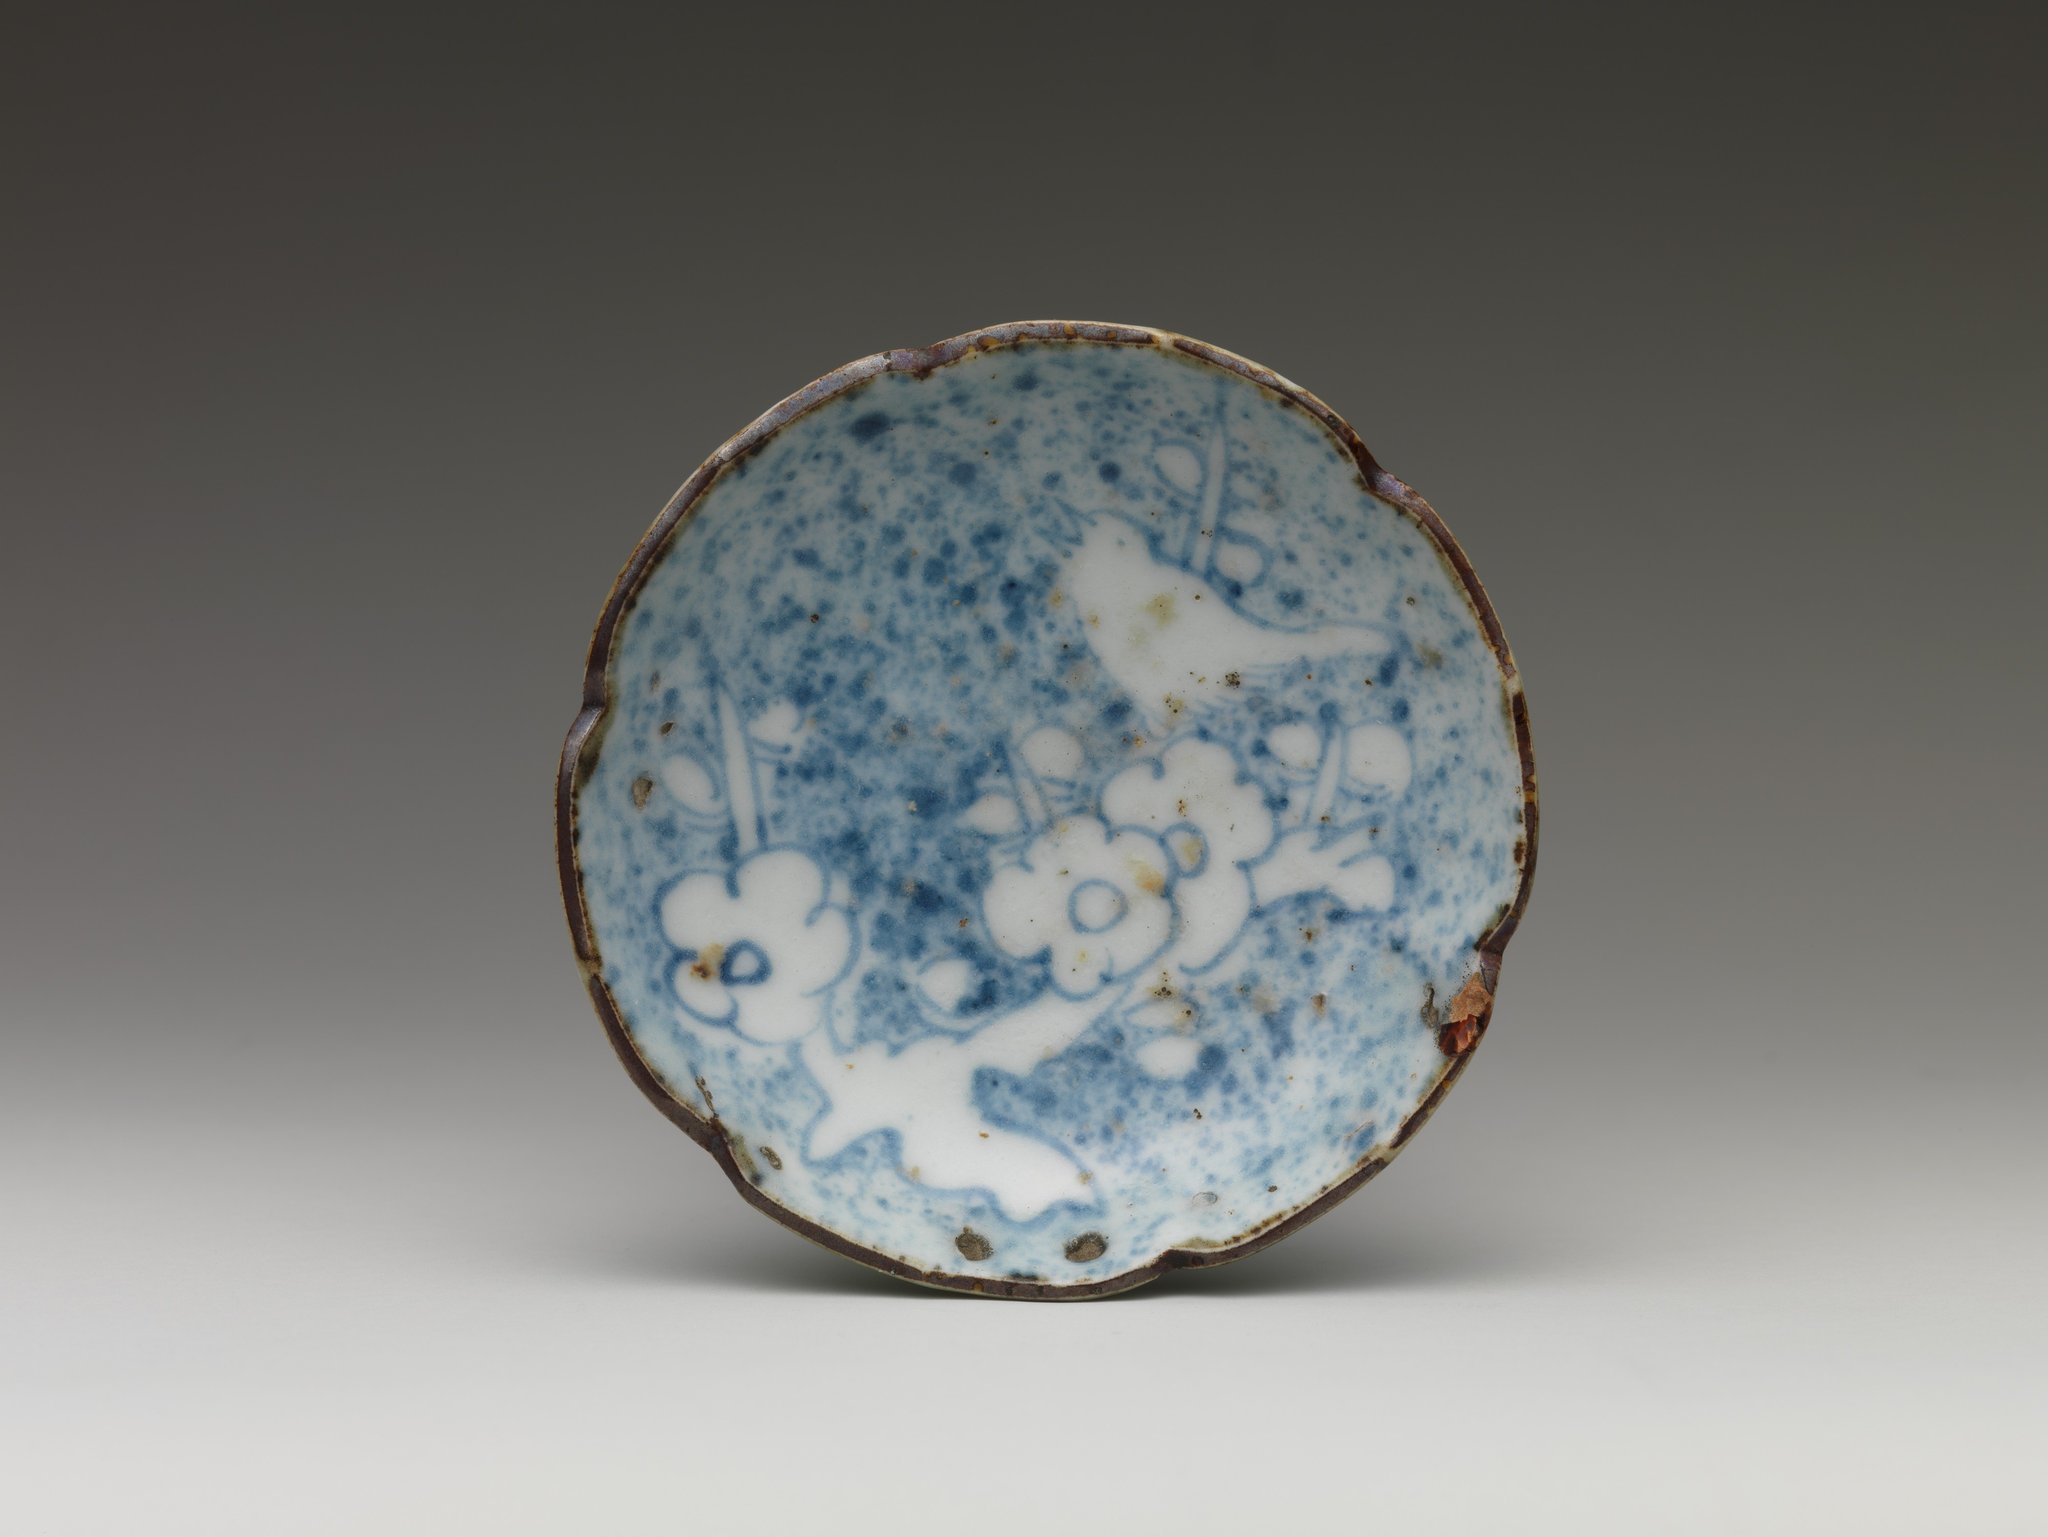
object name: dish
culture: japanese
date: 1640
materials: porcelain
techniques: underglaze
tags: birds